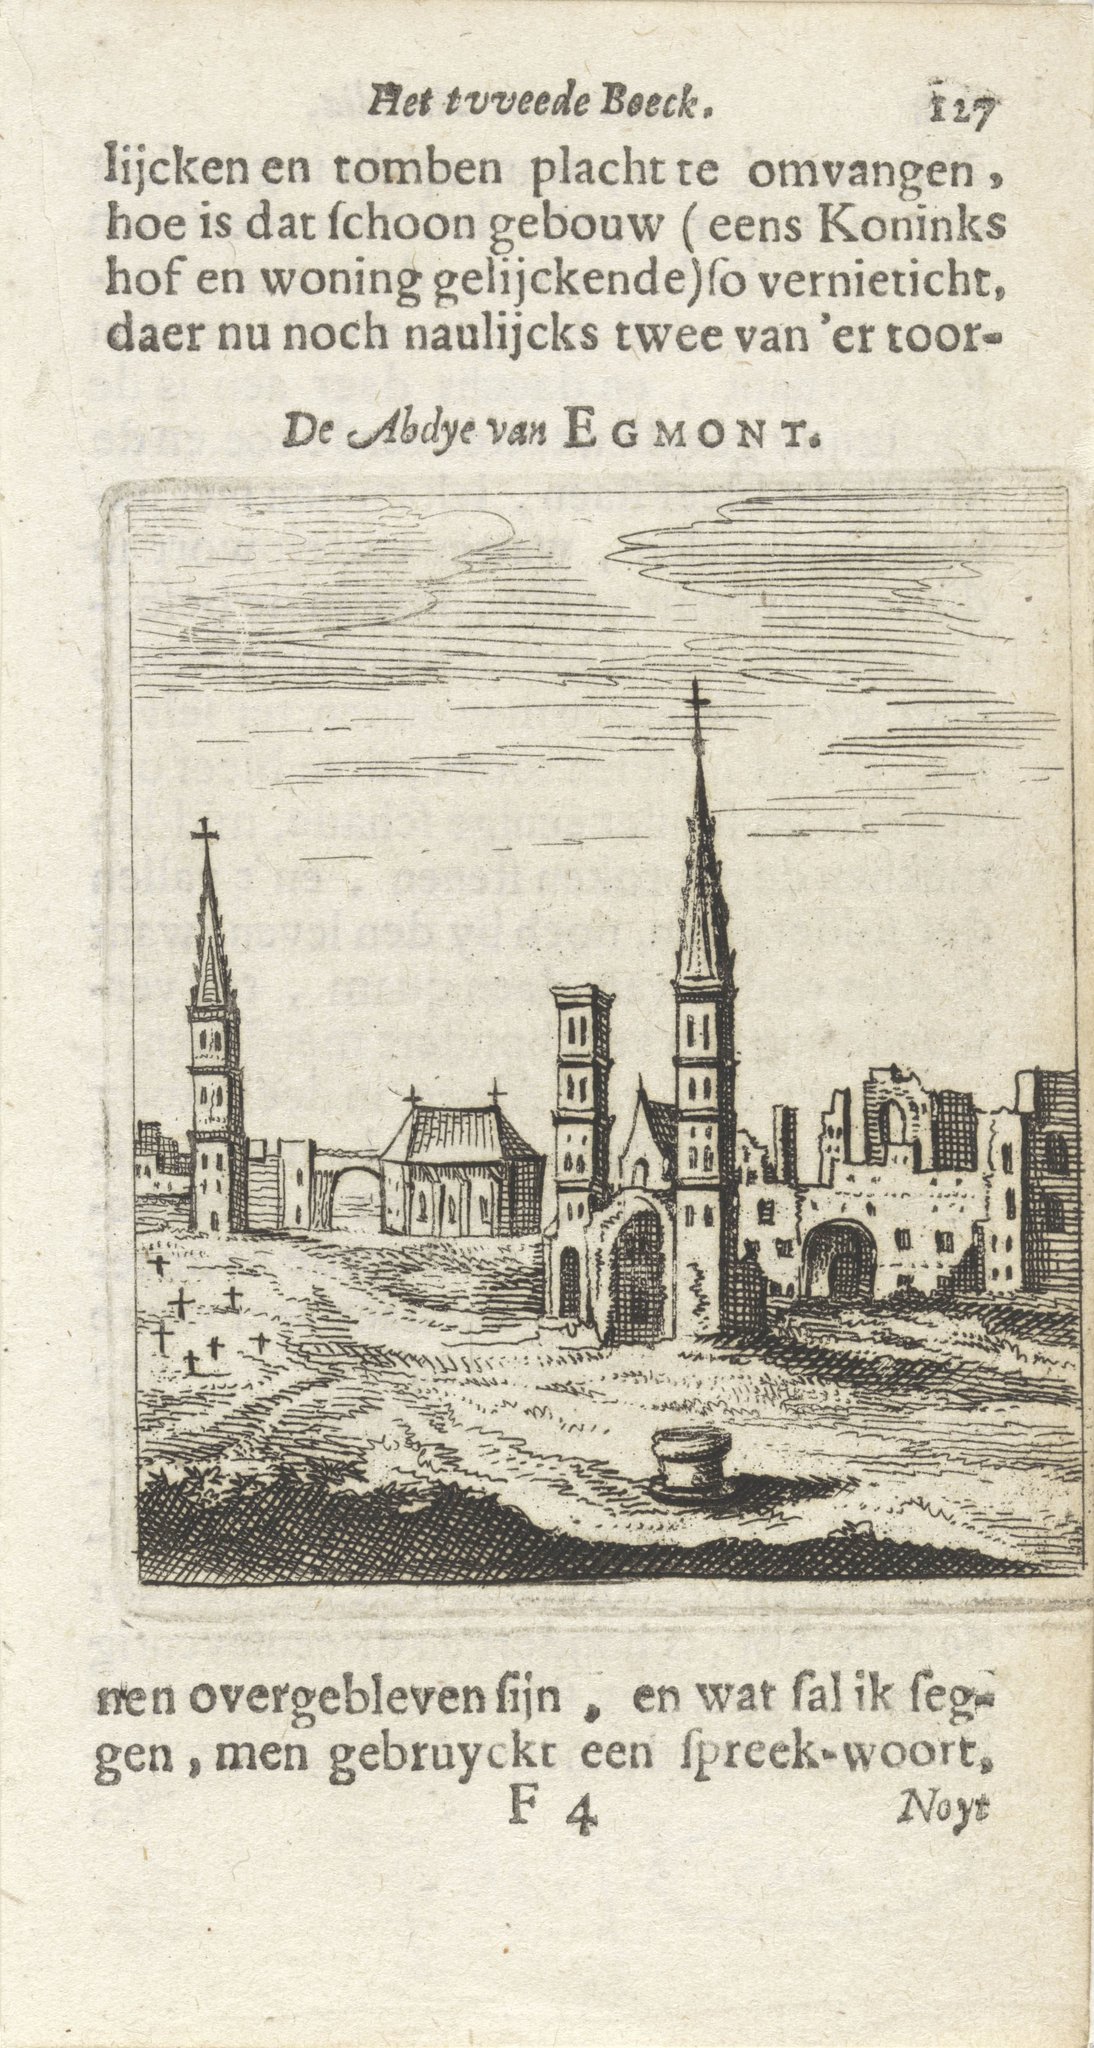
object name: book illustration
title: De abdye van Egmont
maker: hendrik jacobsz soeteboom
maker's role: print maker, publisher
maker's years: 1616-1678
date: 1658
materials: paper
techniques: engraving, etching, letterpress printing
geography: zaandam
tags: abbey, monastery, convent ~ roman catholic church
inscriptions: collector's mark: Lugt 2228, collector's mark: Lugt 2760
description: Gebruikt als illustratie op p. 127 van: Hendrik Jacobsz Soeteboom. De Zaanlants Arkadia. Amsterdam: Gerrit van Goedesberg, 1658.